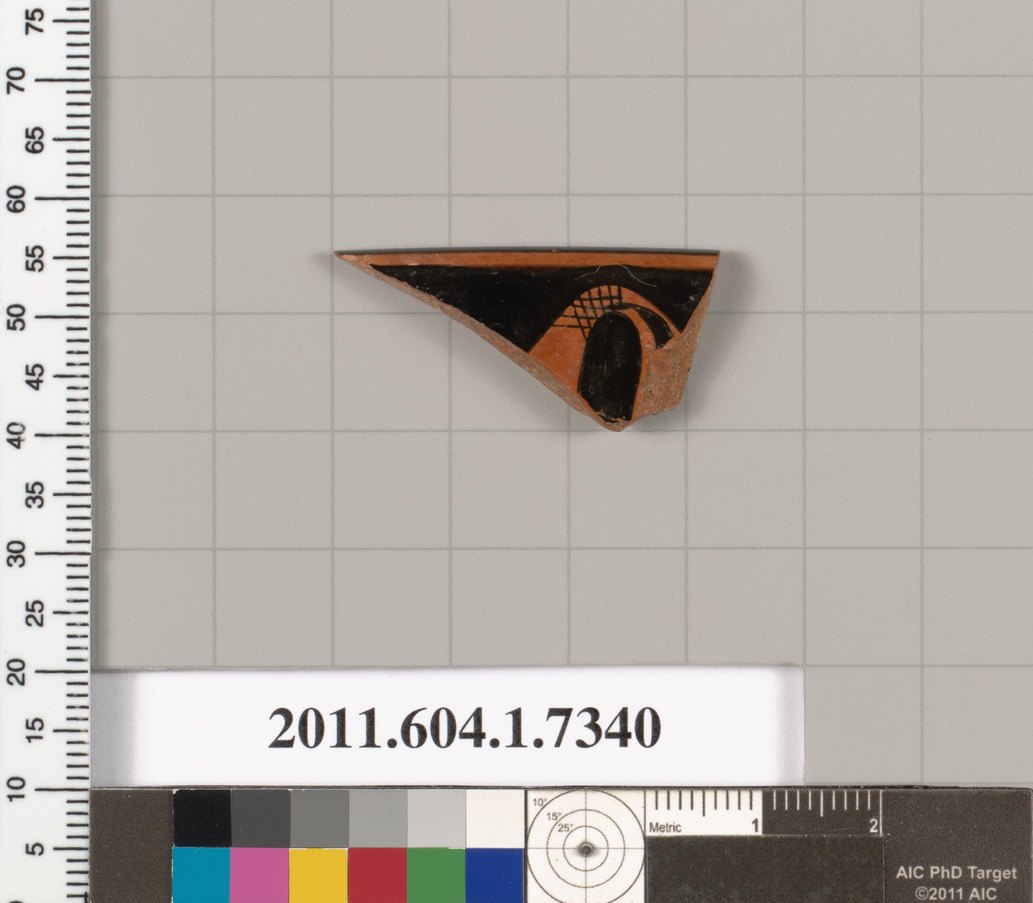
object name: kylix fragment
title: Terracotta rim fragment of a kylix (drinking cup)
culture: greek, attic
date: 500-480 BCE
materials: terracotta